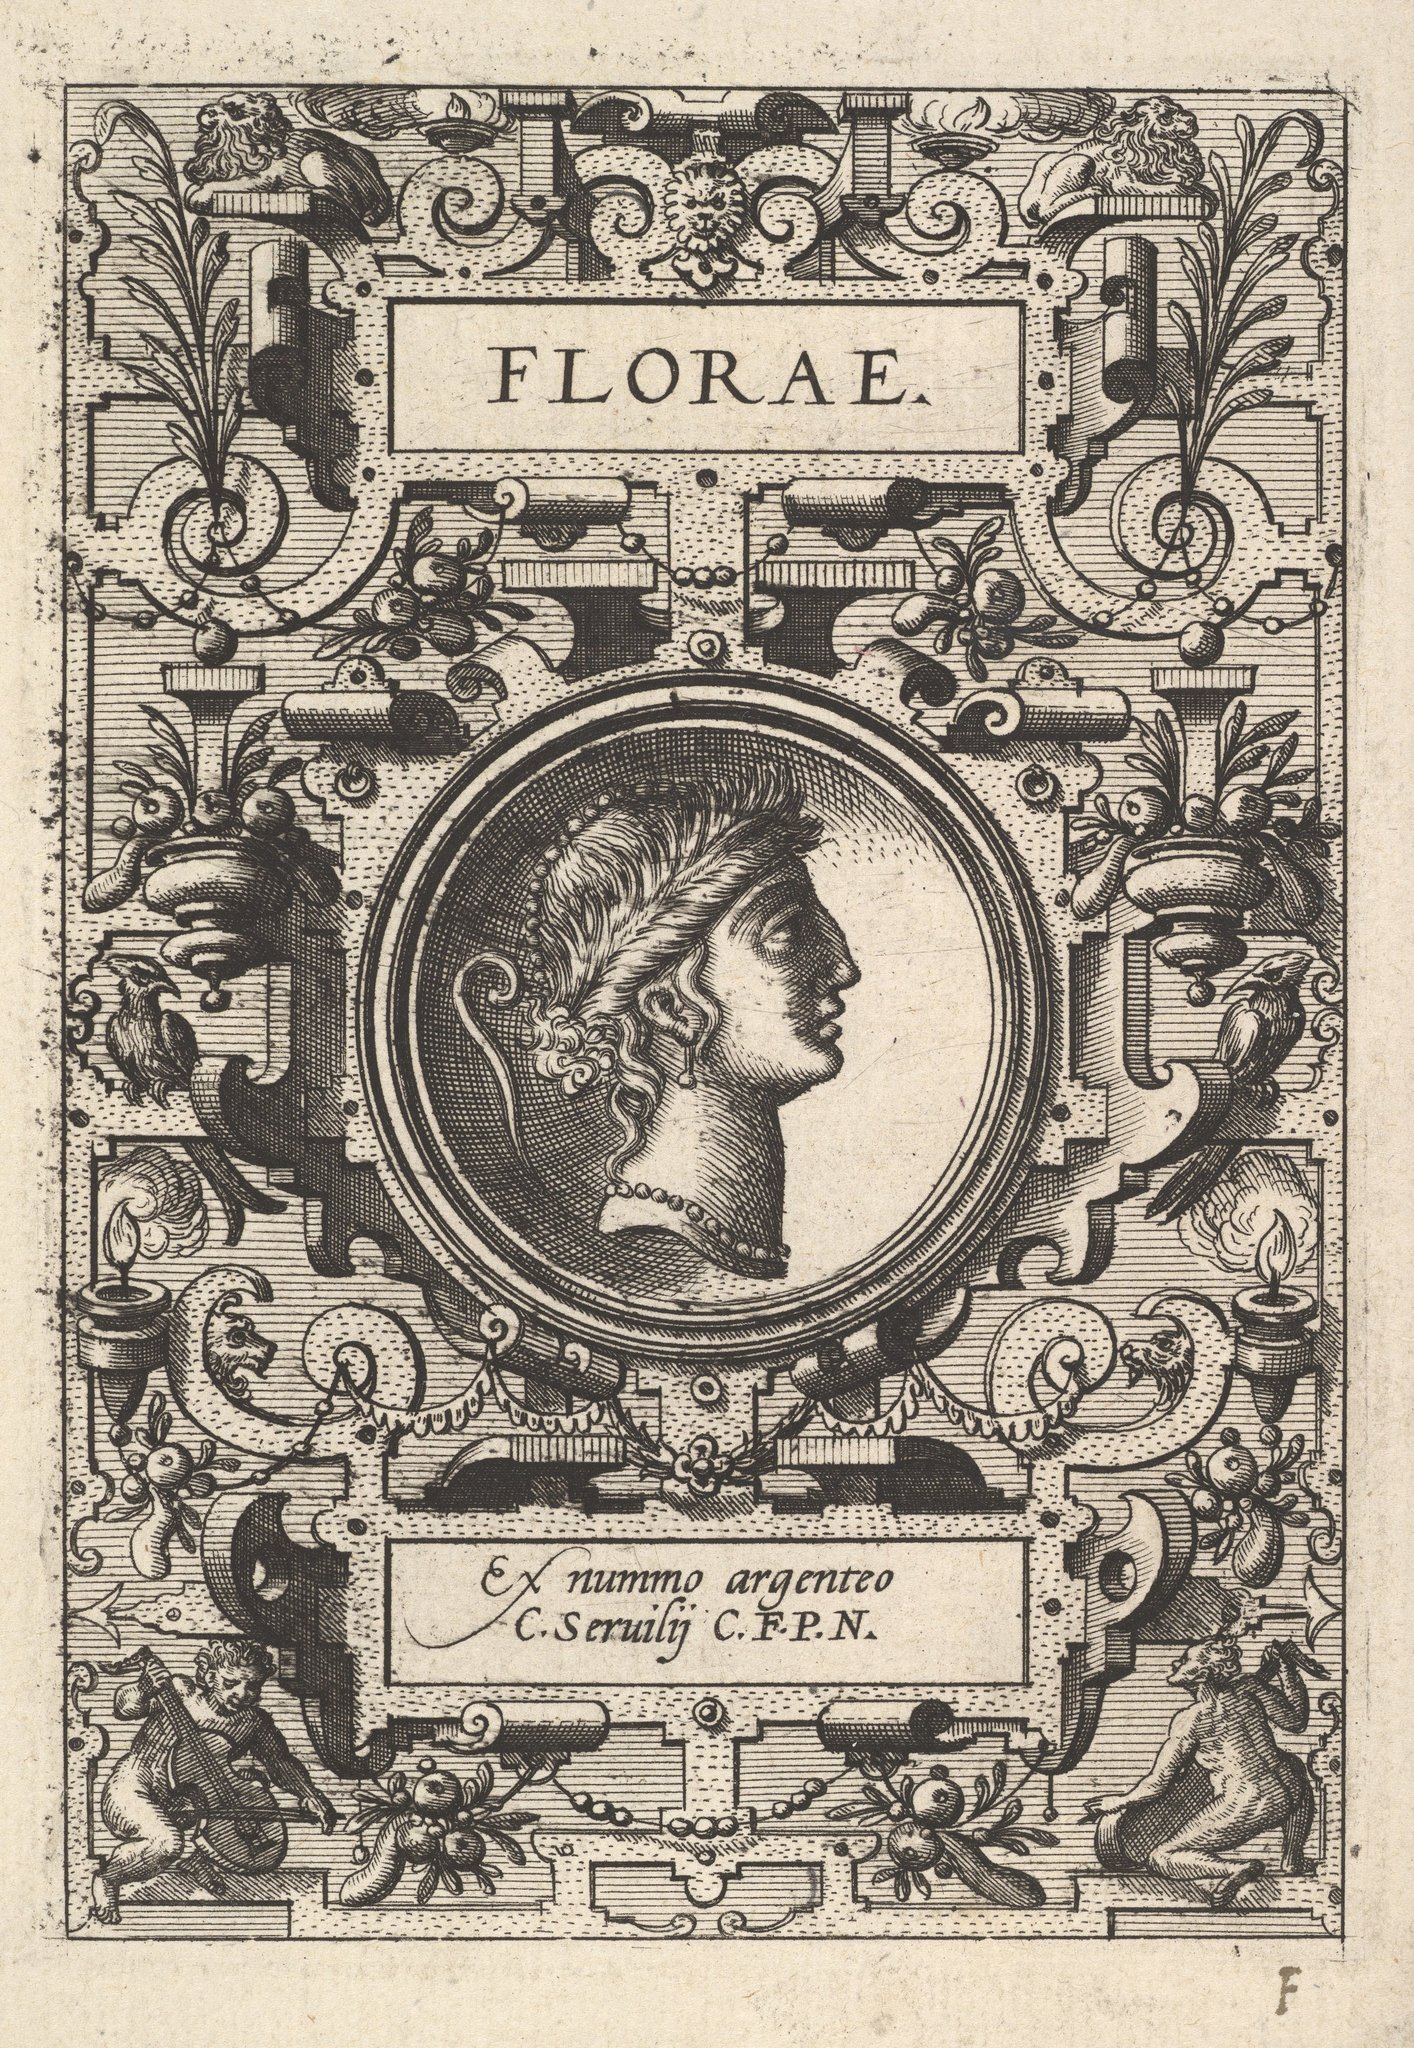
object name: print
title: Bust of Florae surrounded by strapwork, from "Deorum dearumque"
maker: hans vredeman de vries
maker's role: artist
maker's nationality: netherlandish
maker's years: 1527-1606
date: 1573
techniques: etching